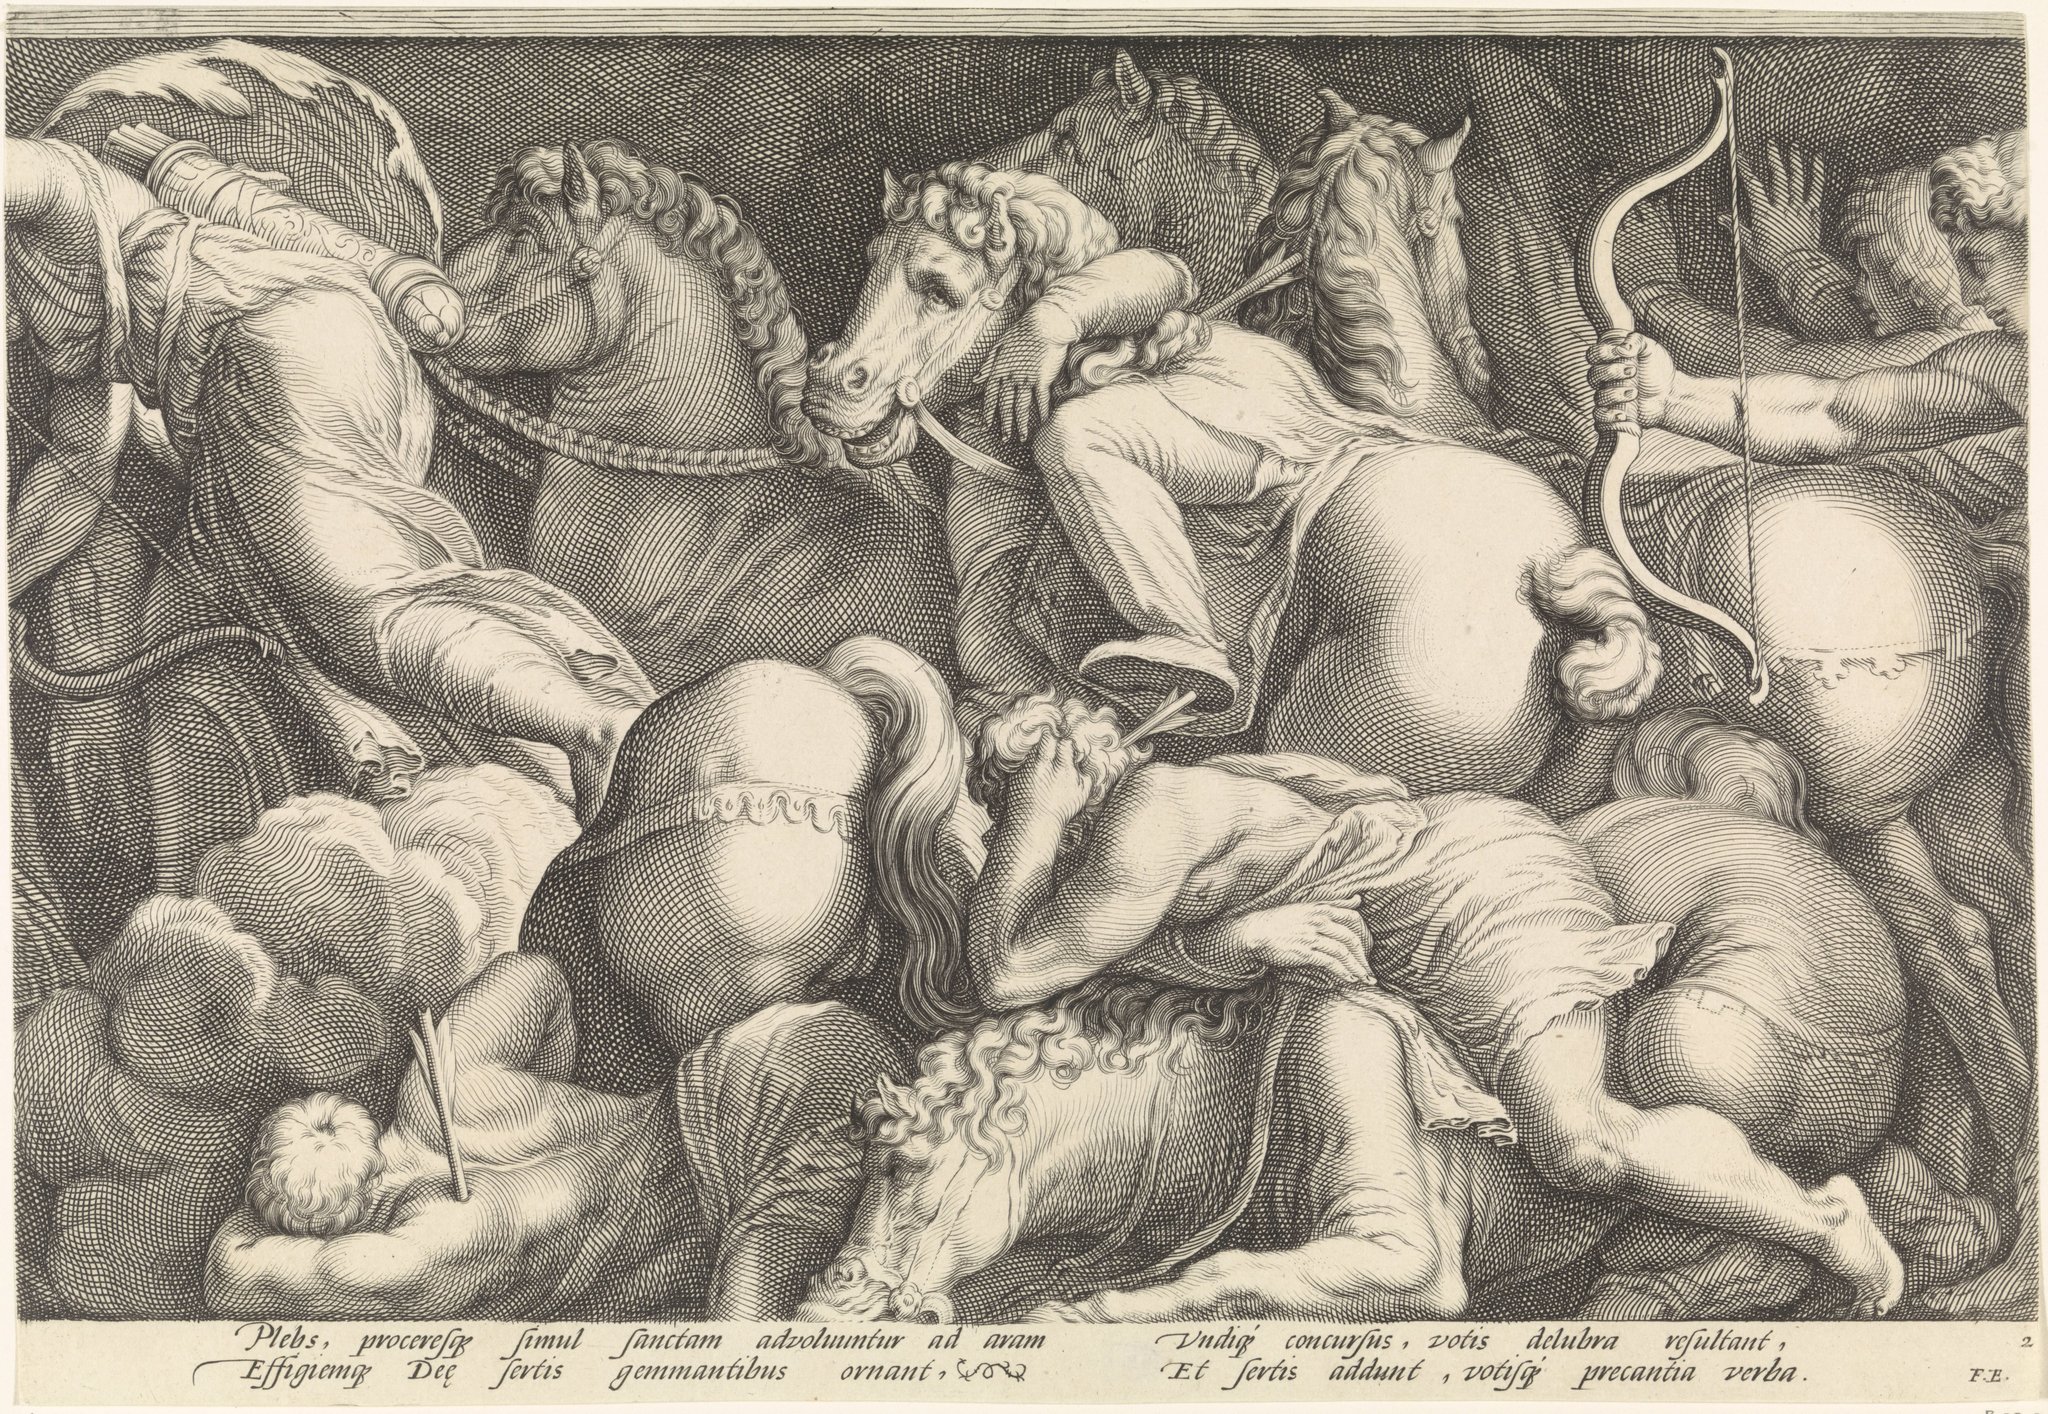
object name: print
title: Fries met de bestraffing van Niobe (plaat 2)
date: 1594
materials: paper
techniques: engraving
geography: rome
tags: apollo and diana kill niobe's children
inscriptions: collector's mark: Lugt 2228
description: De veertien kinderen van Niobe worden door Apollo en Diana door pijlen gedood. De prent heeft een Latijnse onderschrift. Linkerplaat van een prent met een fries uit acht platen.